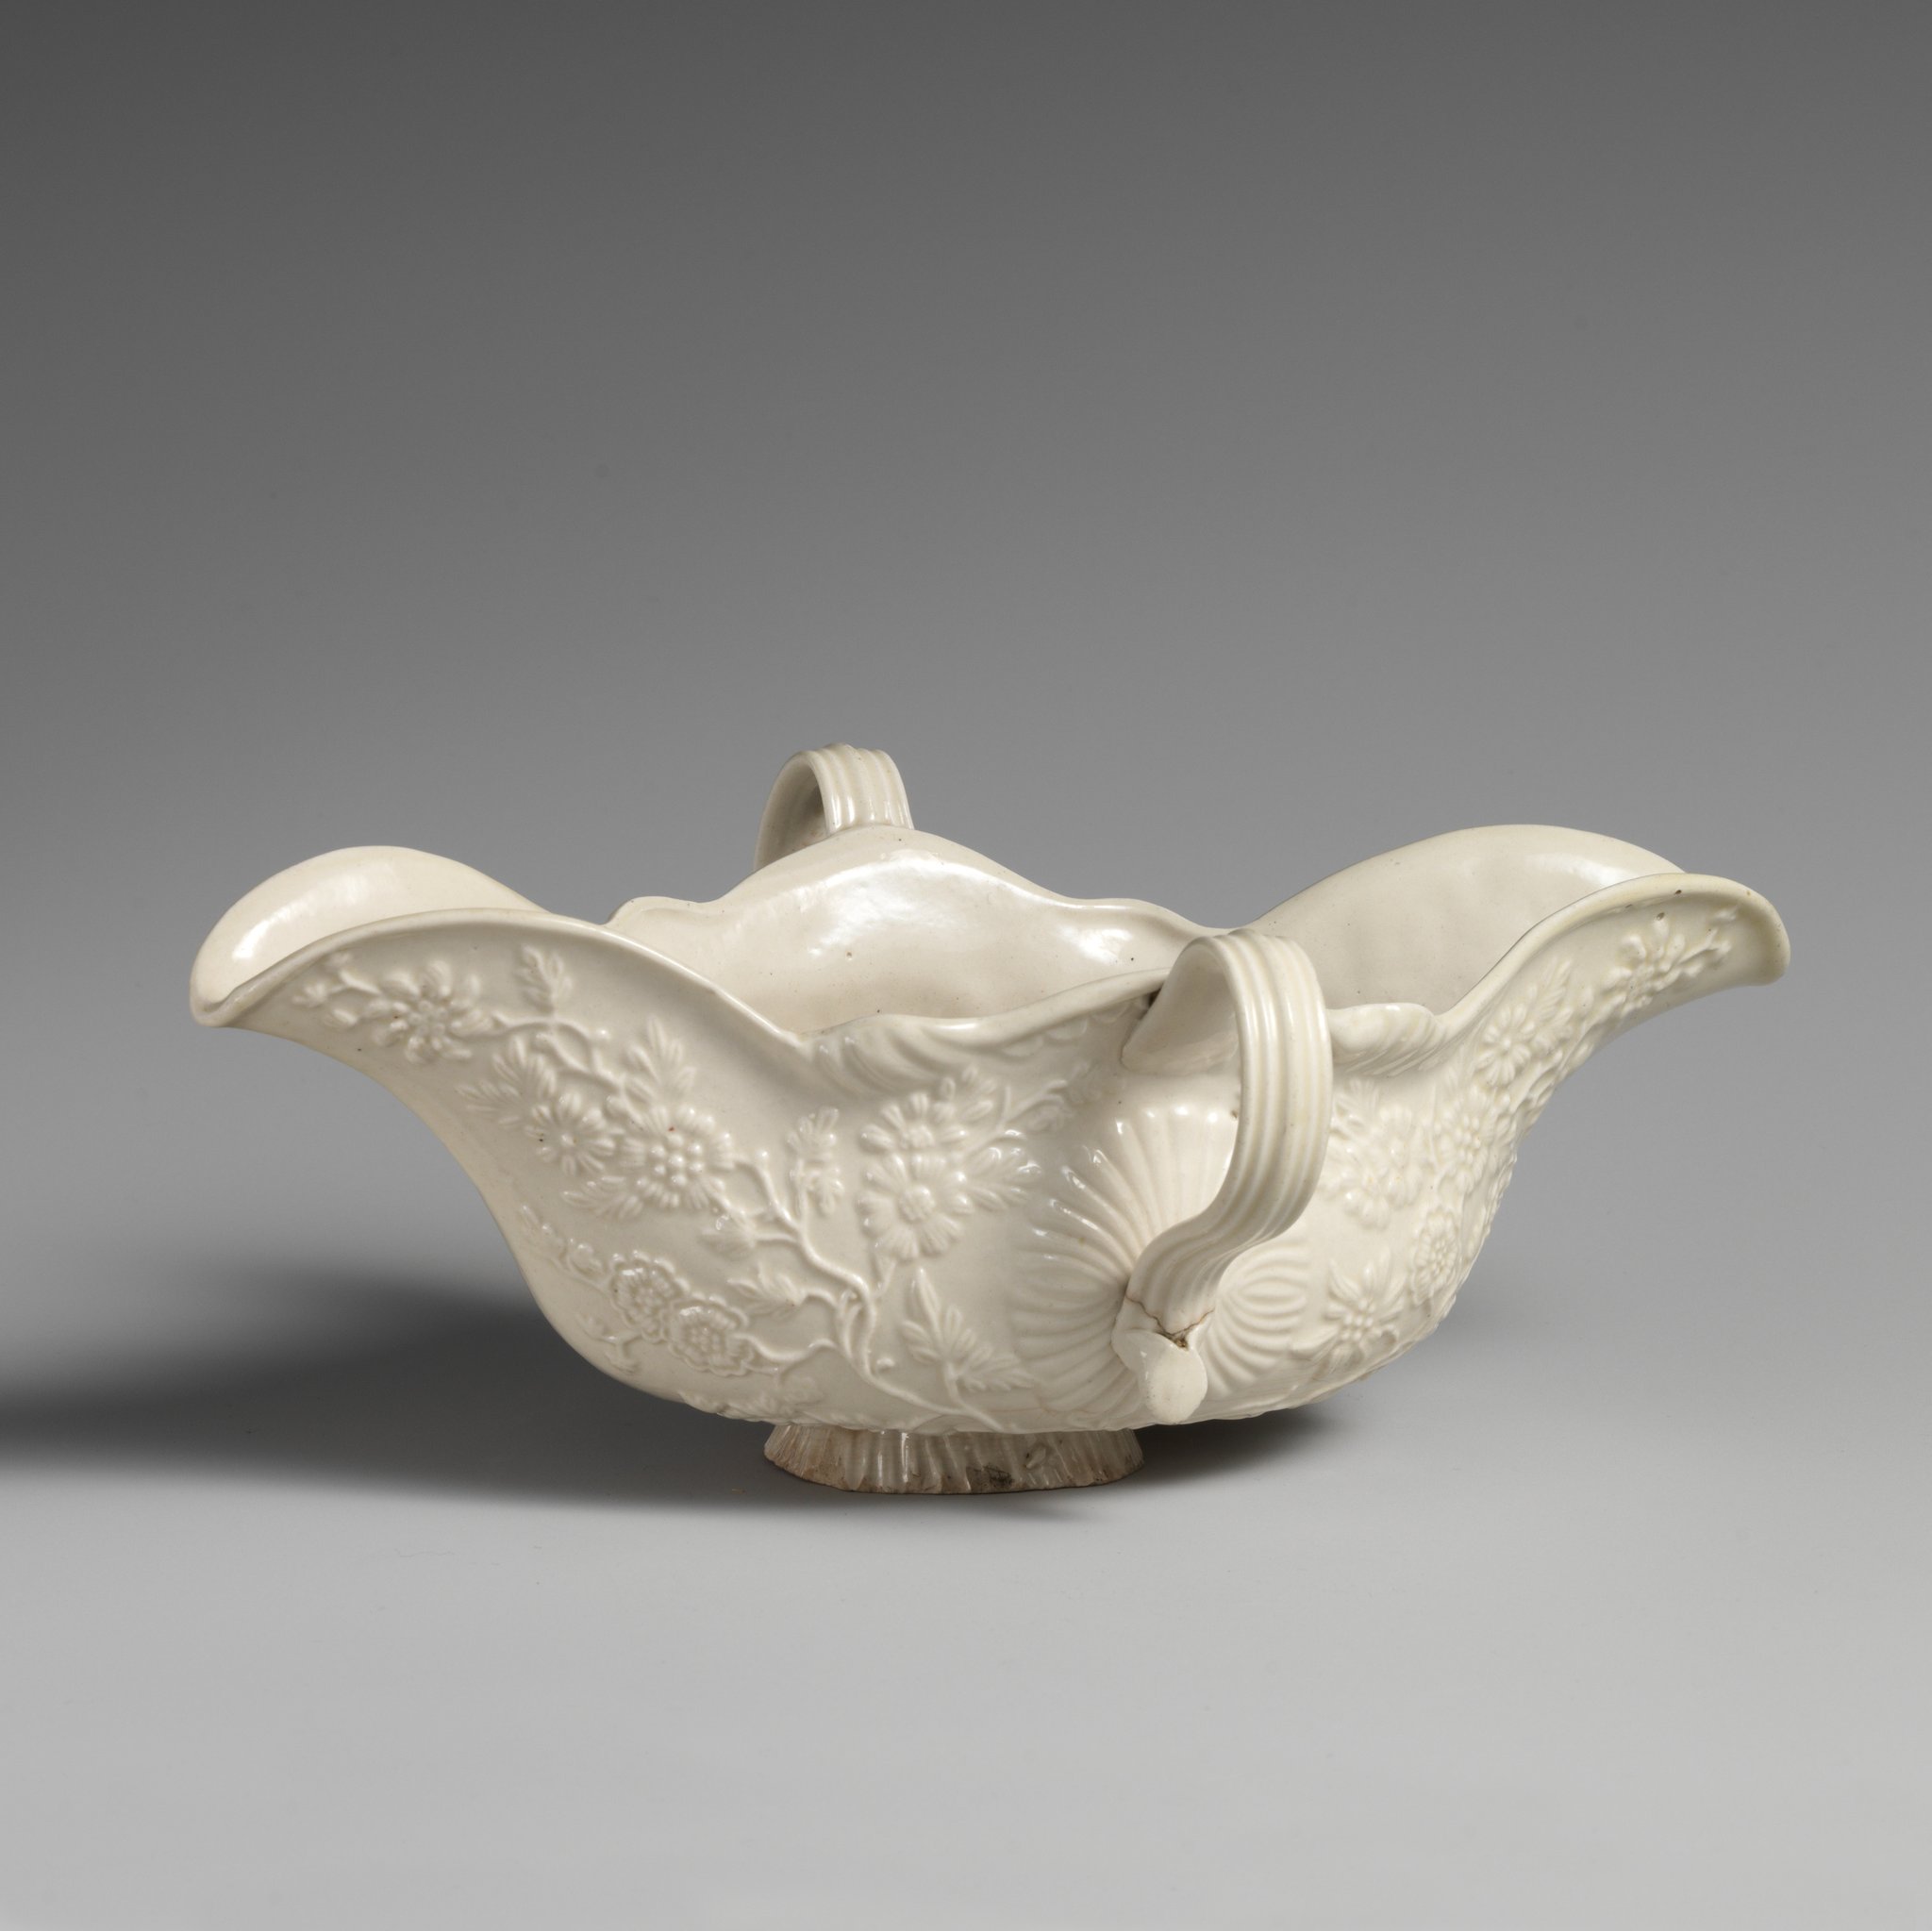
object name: sauceboat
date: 1750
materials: stoneware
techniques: salt glaze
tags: flowers